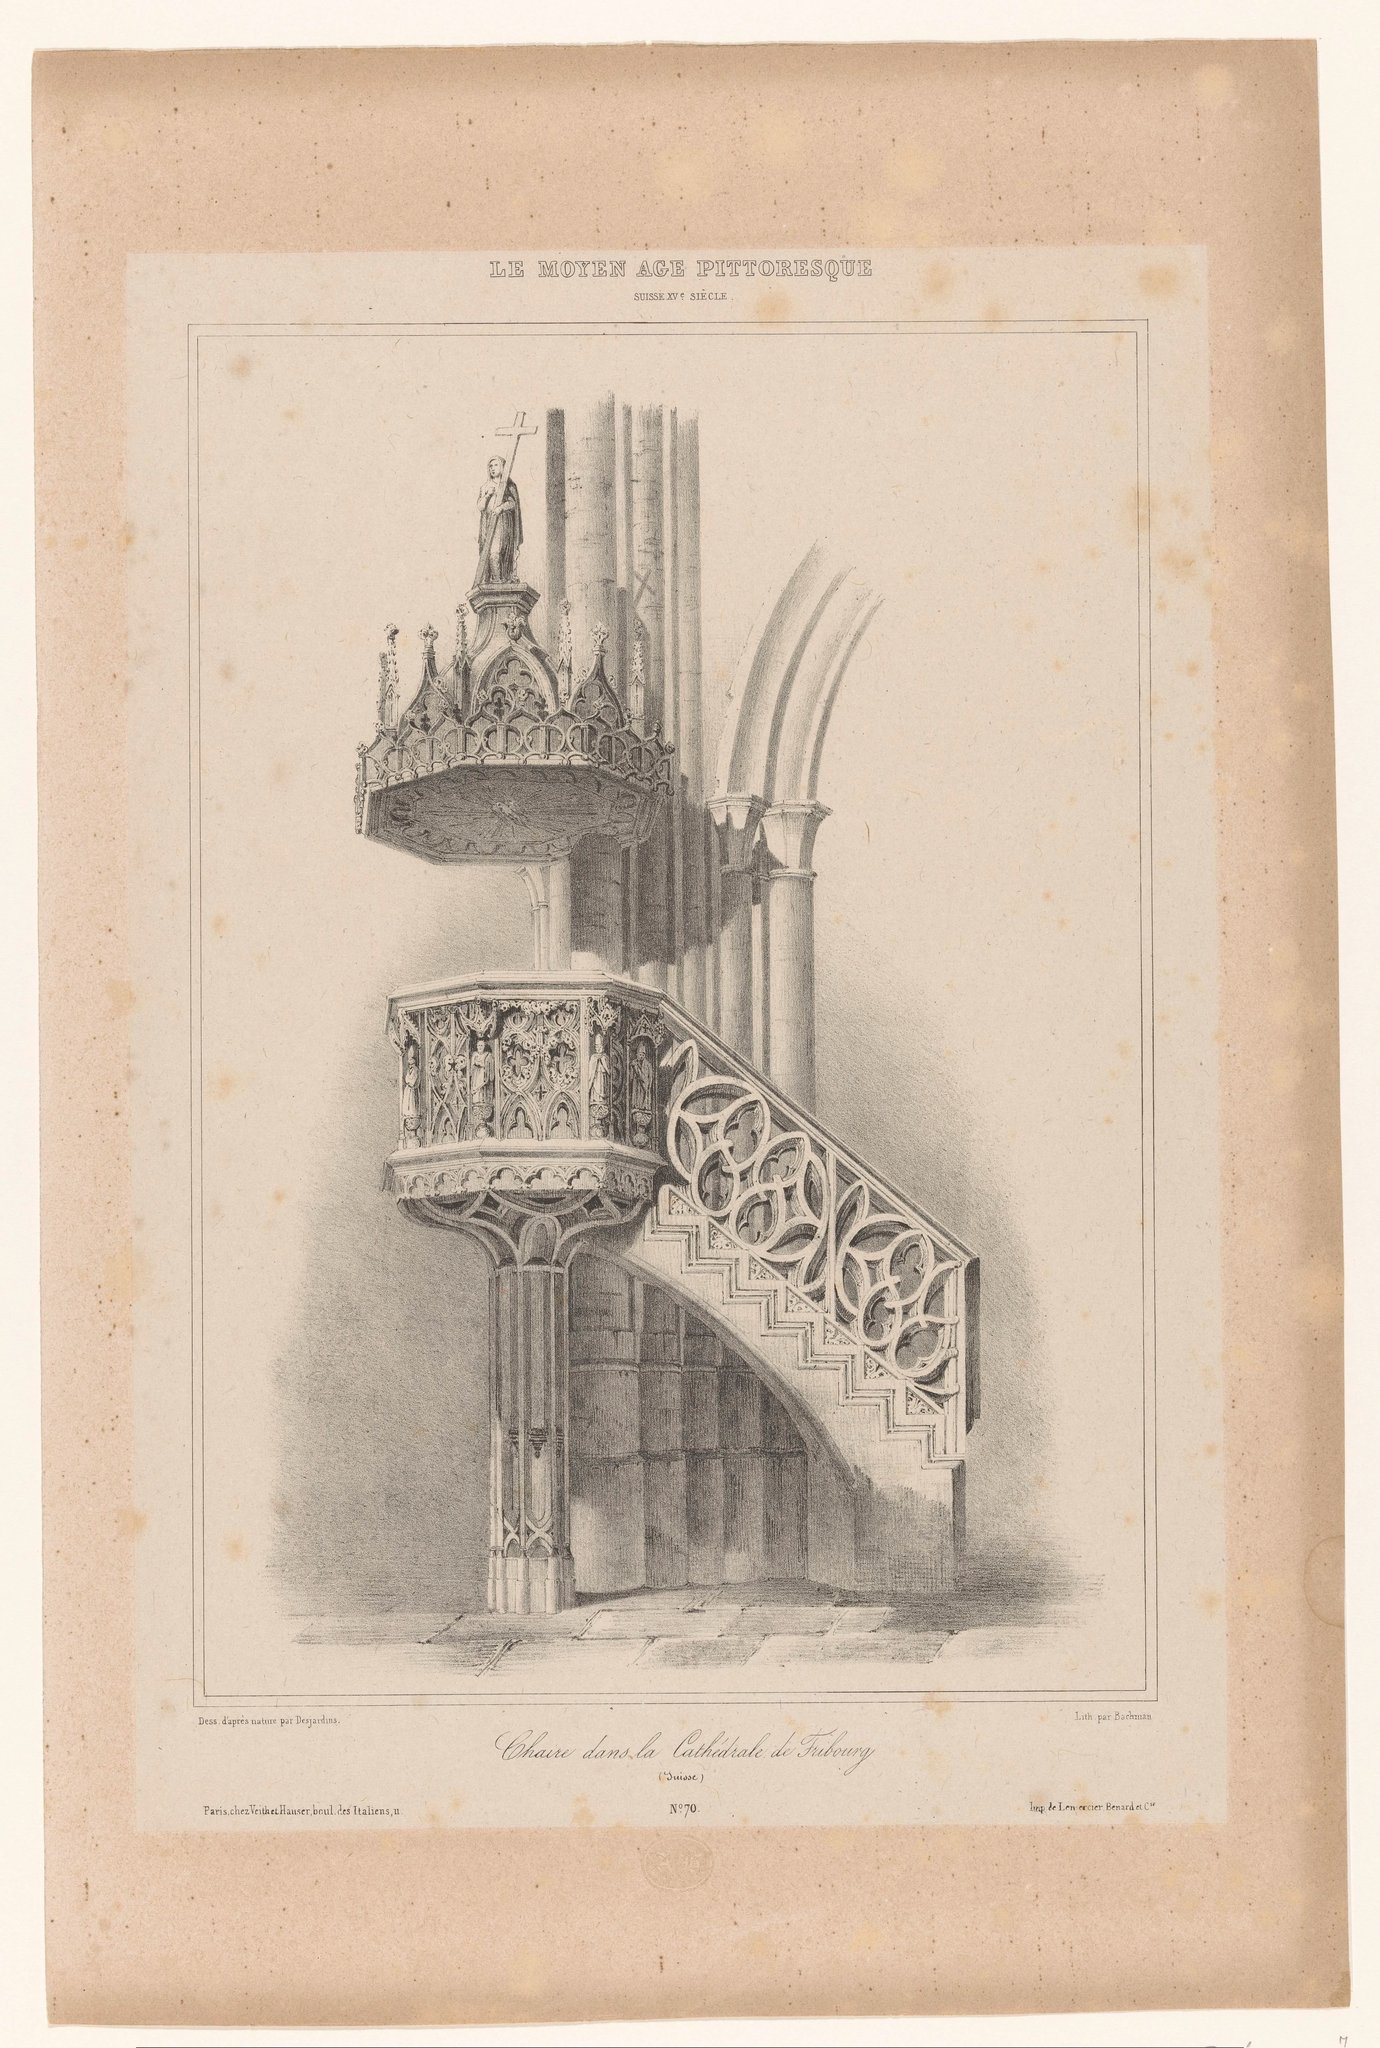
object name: print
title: Pittoreske middeleeuwen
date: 1837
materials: paper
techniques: lithograph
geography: paris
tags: pulpit, ambo, chancel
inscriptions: check stamp: Lugt 4210, collector's mark: Lugt 2228a